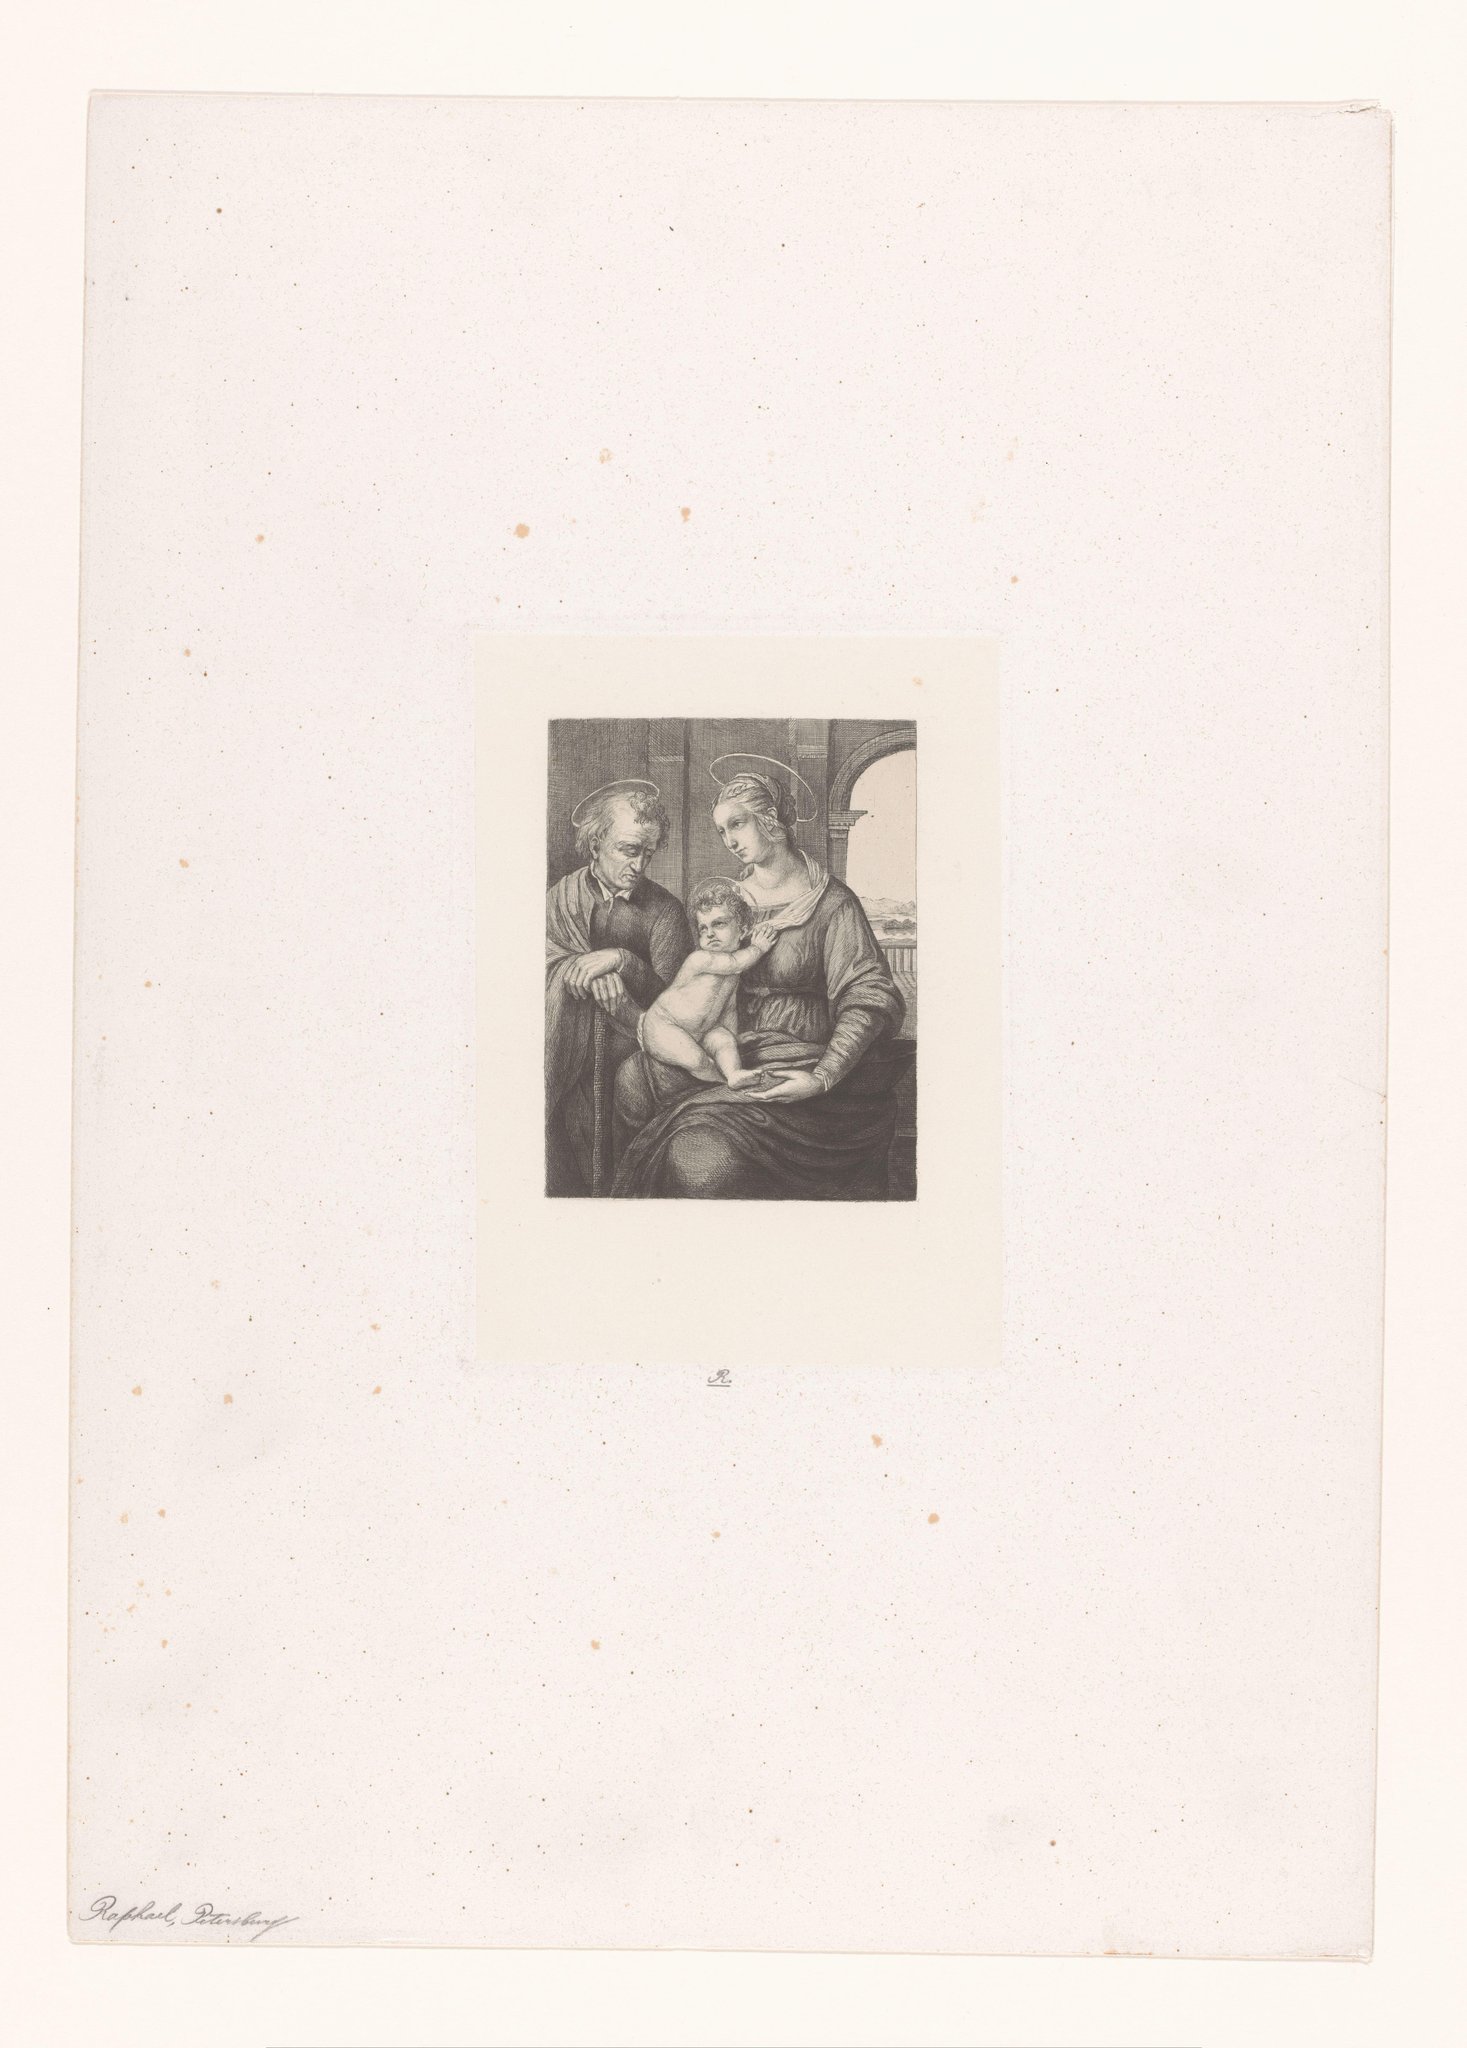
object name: print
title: Heilige Familie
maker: nikolay semyonovich mosolov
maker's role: print maker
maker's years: 1847-1914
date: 1857-1914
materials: paper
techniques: drypoint, etching, intaglio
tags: holy family (alone), 'trinitas terrestris'